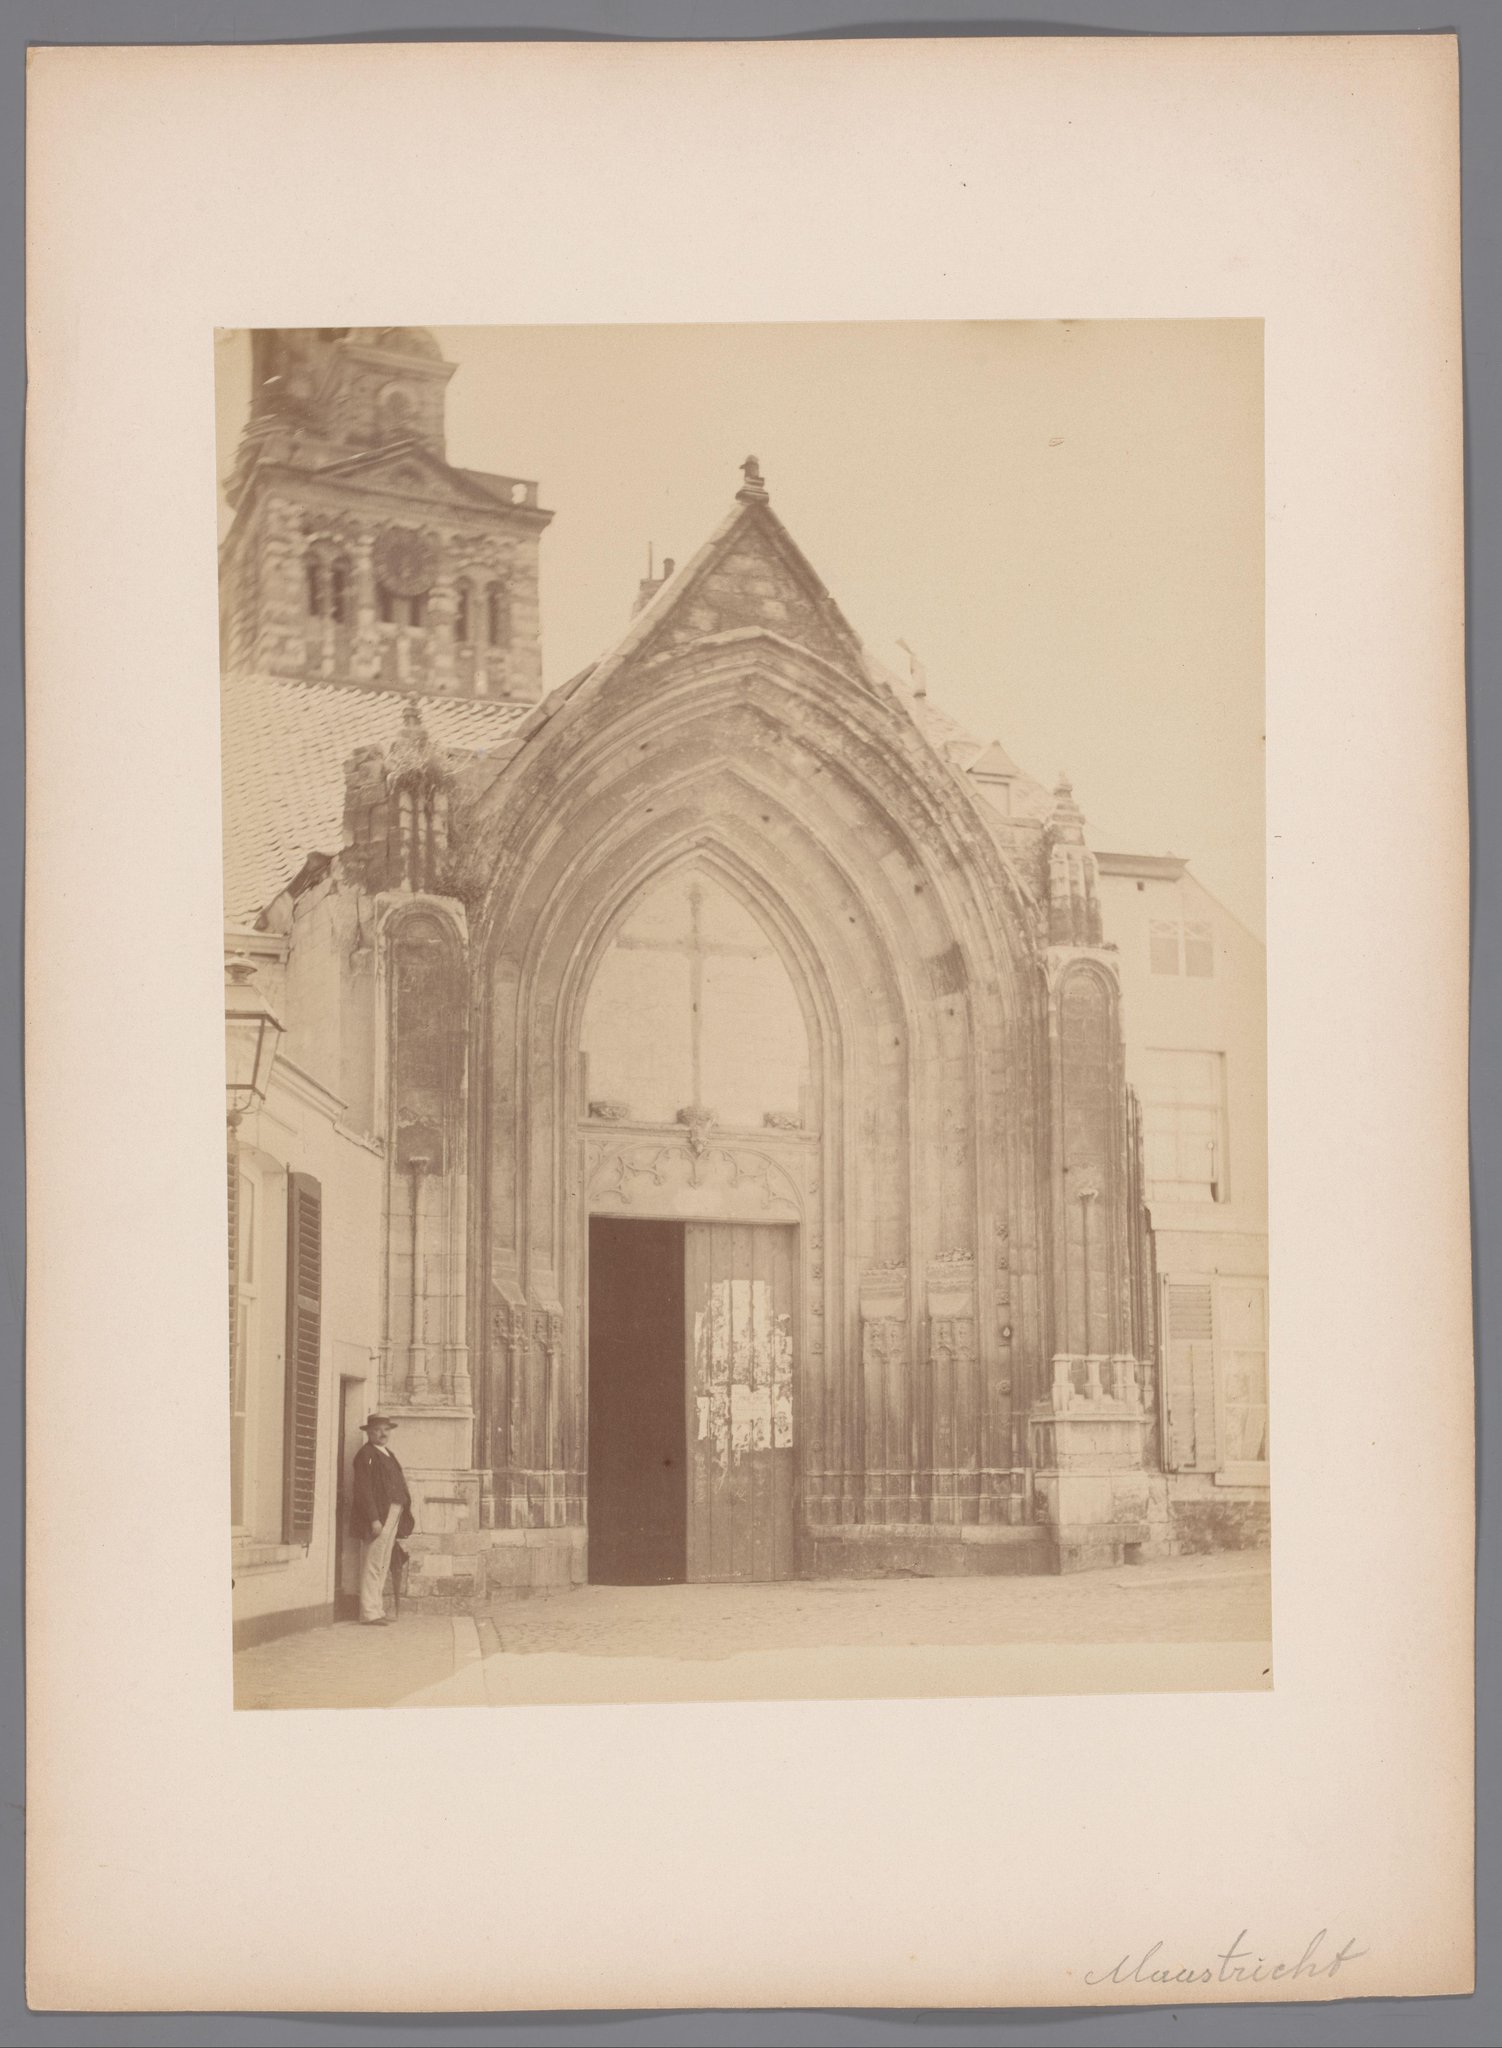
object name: photograph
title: Gezicht op het noordelijk portaal van de Sint-Servaasbasiliek te Maastricht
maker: anoniem (monumentenzorg)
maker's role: fotograaf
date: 1893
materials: cardboard, photographic support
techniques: albumen print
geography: maastricht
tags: parts of church exterior and annexes: portal, parts of church exterior and annexes: tympanum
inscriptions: annotation: ‘Maastricht’, annotation: ‘Maastricht St. Servaas/ Noordportaal voor de restauratie’